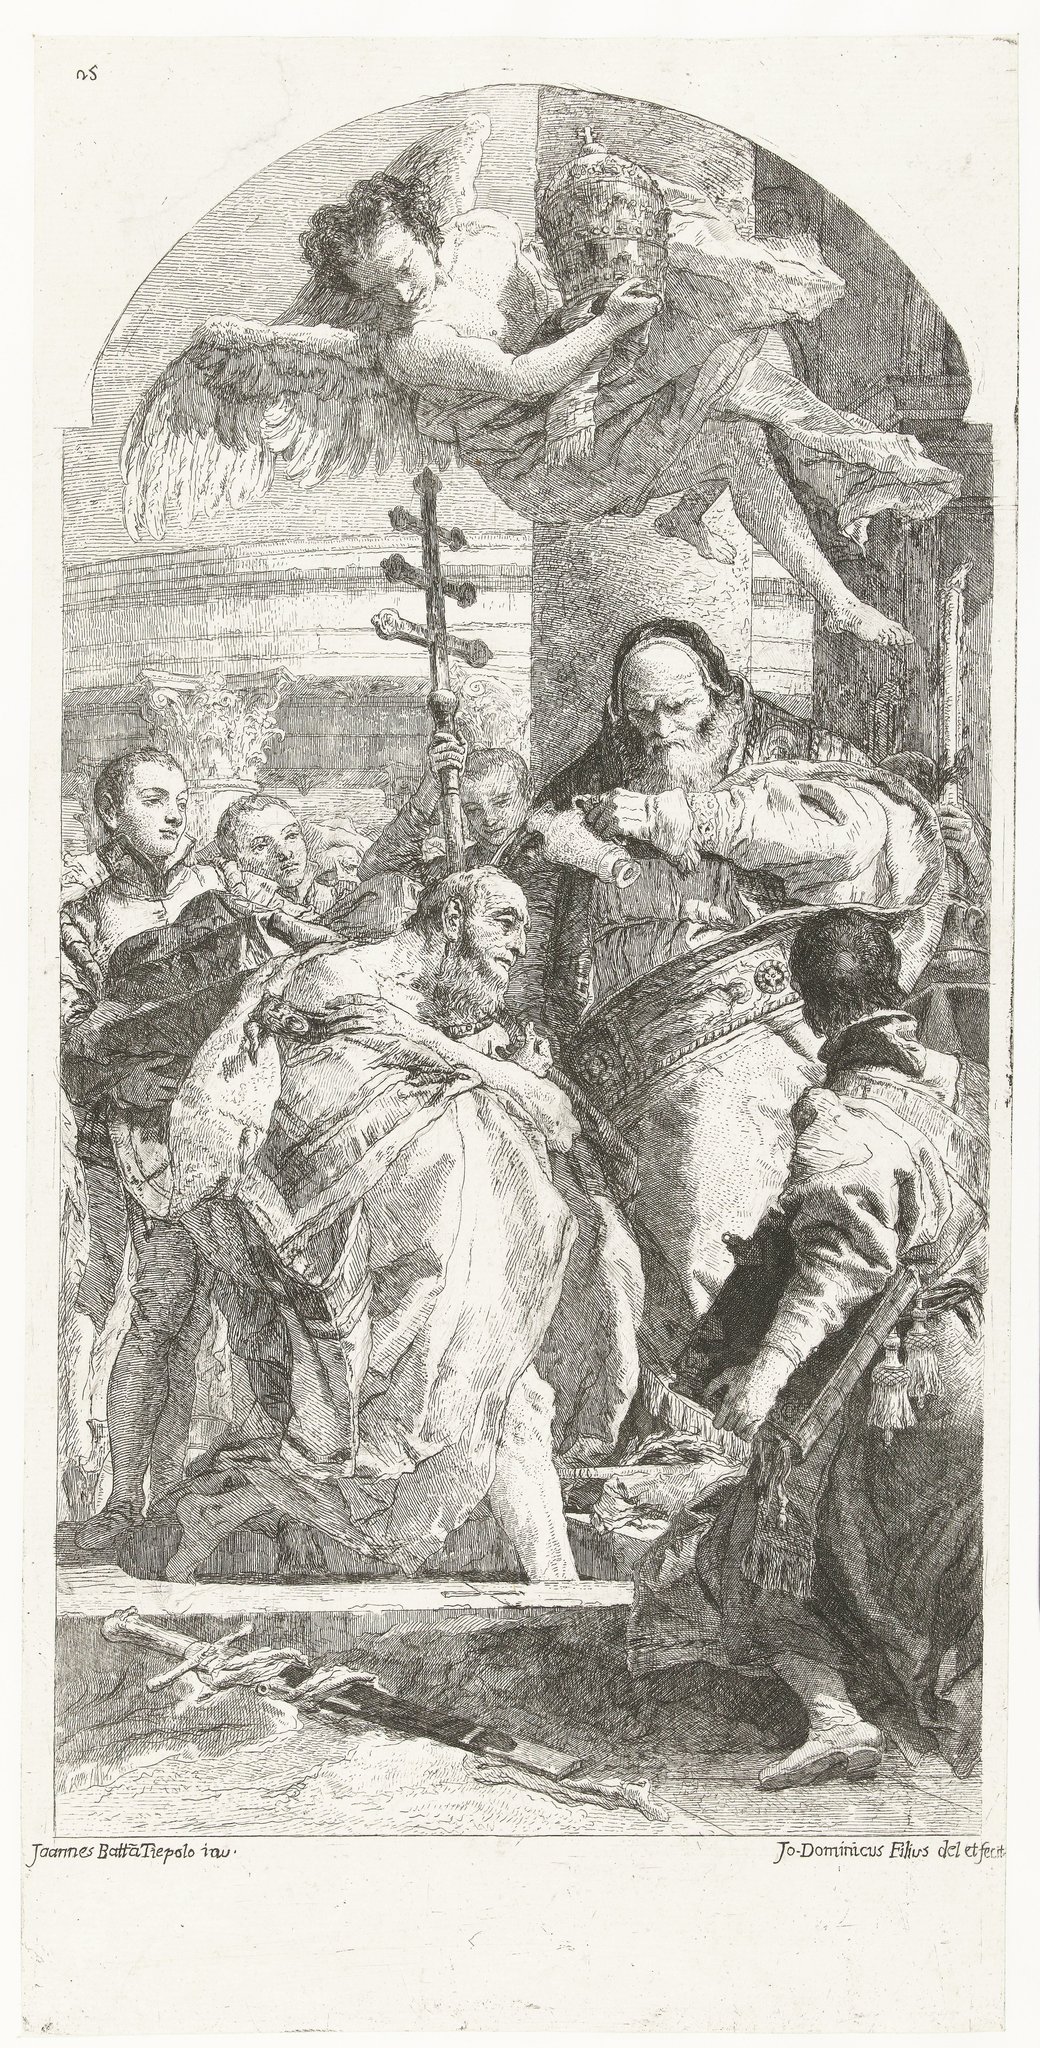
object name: print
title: Doop van keizer Constantijn de Grote door paus Silvester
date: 1757-1761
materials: paper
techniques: etching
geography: venice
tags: st. sylvester baptizes emperor constantine the great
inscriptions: collector's mark: Lugt 2228, collector's mark: Lugt 2760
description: Prent naar altaarstuk van Giovanni Battista Tiepolo. Op deze prent ontbreekt de opdracht in de marge onder de voorstelling die beschreven wordt bij Rizzi 1971, p. 294.